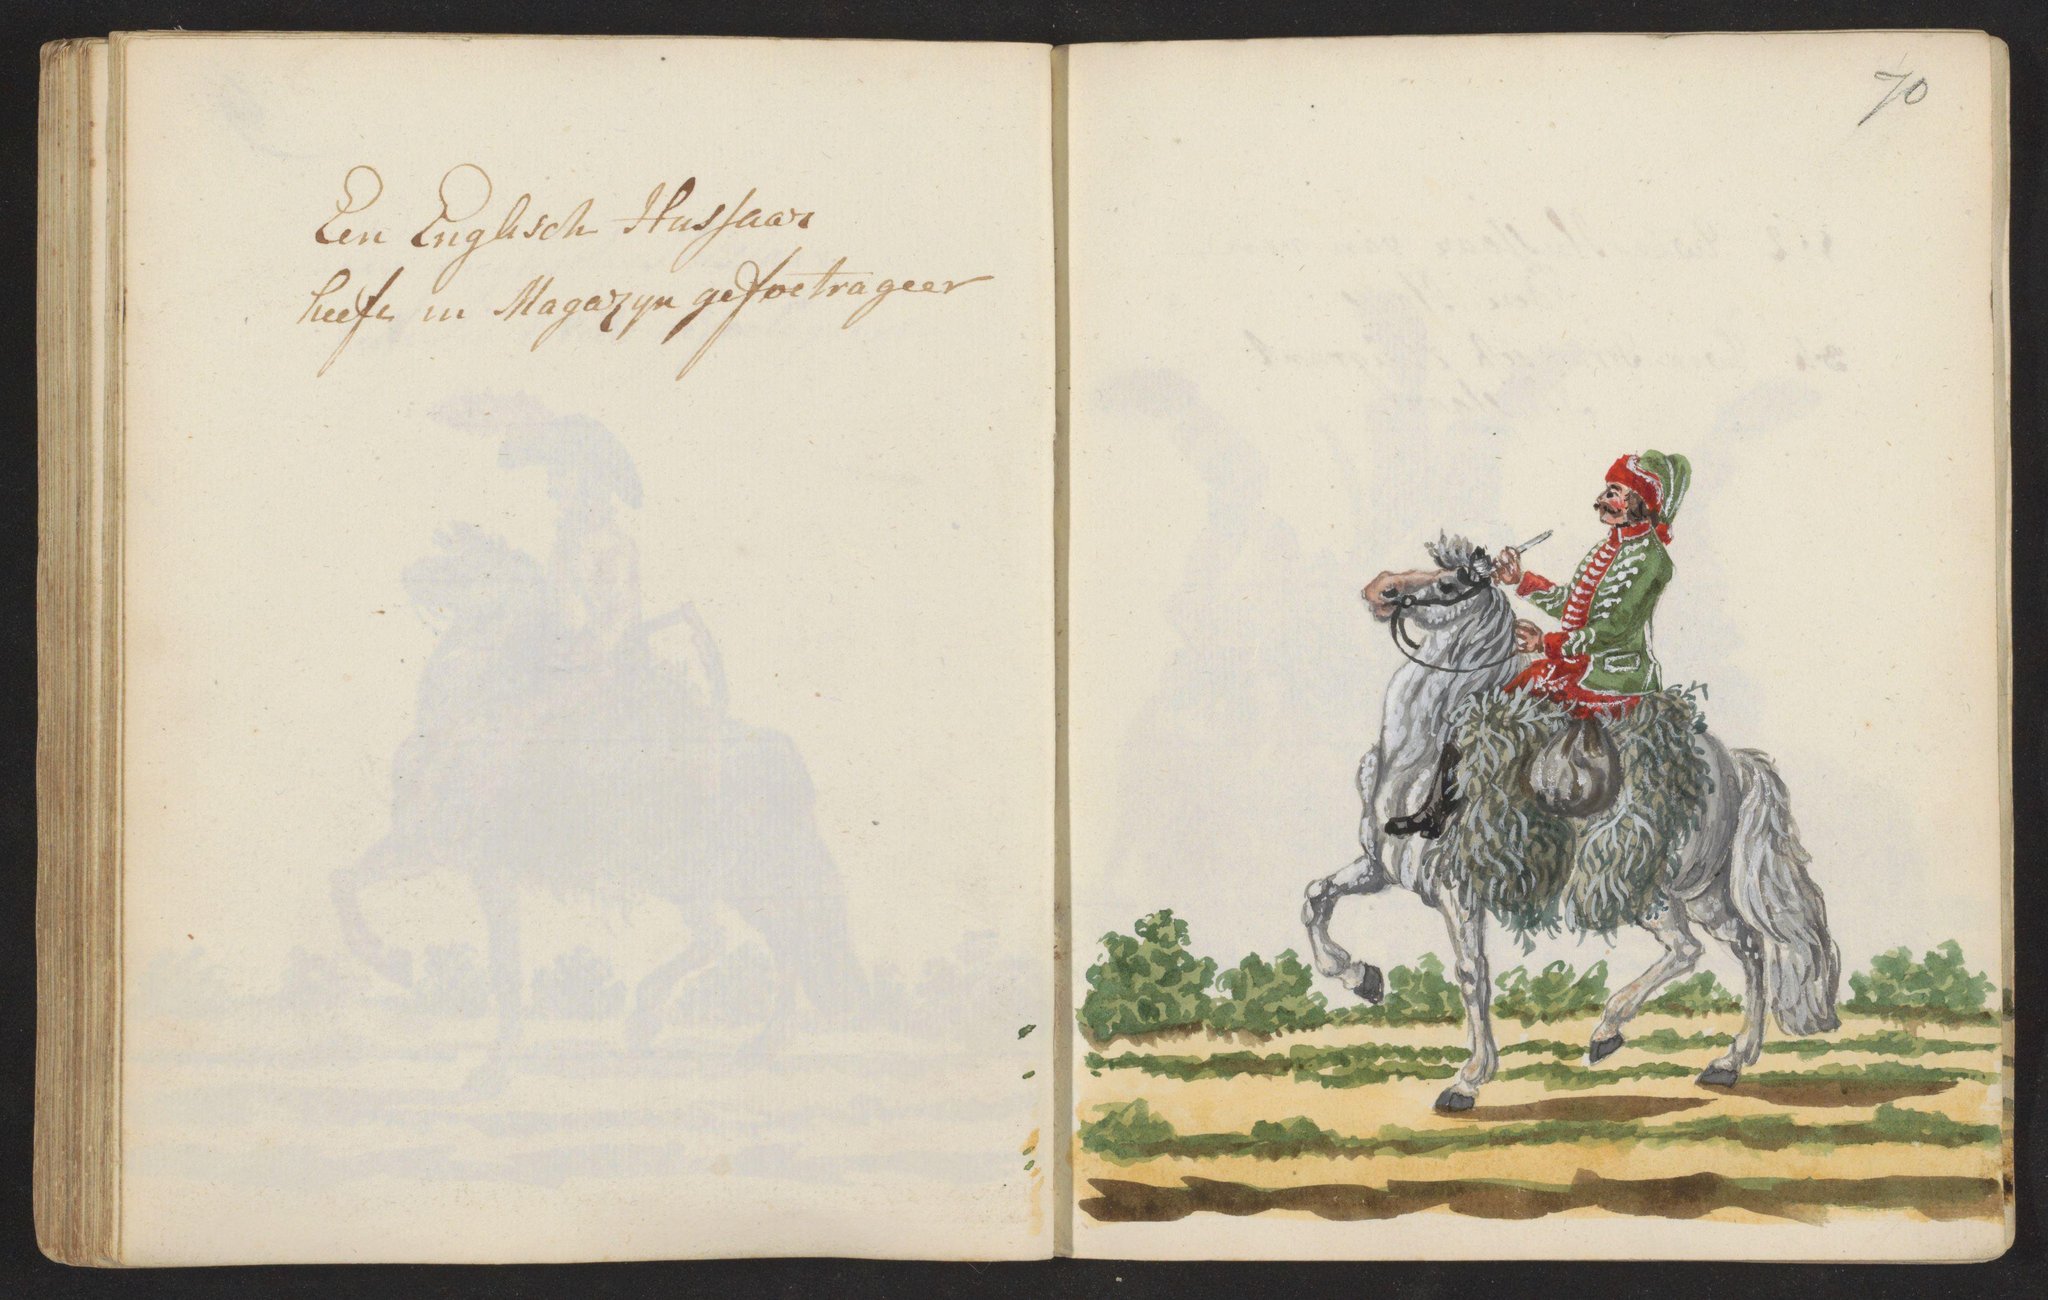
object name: drawing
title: Een Englisch Hussaar heeft in Magazyn gefoelrageer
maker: s.g. casten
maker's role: draughtsman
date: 1795-1796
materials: paper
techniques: writing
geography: amsterdam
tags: (military) uniforms (+ infantry), patriots (1780-1795)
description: Het uniform van een Engelse huzaar te paard die in het veld gefourageerd heeft, ca. 1788-1795. Onderdeel van het derde hoofdstuk over de nieuwe uniformen in de periode na het herstel van de prins van Oranje en de komst van de Pruisische troepen in Holland in 1787. In het schetsboek met gekleurde tekeningen van de uniformen van militairen en leden van de schutterij uit de periode 1770 tot 1795-1796.